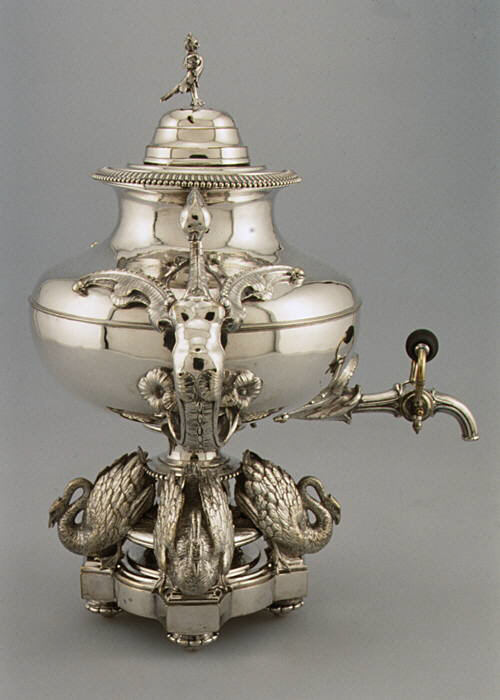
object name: tea urn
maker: p. b., paris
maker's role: maker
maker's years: 1800-1899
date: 1845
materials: silver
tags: swans